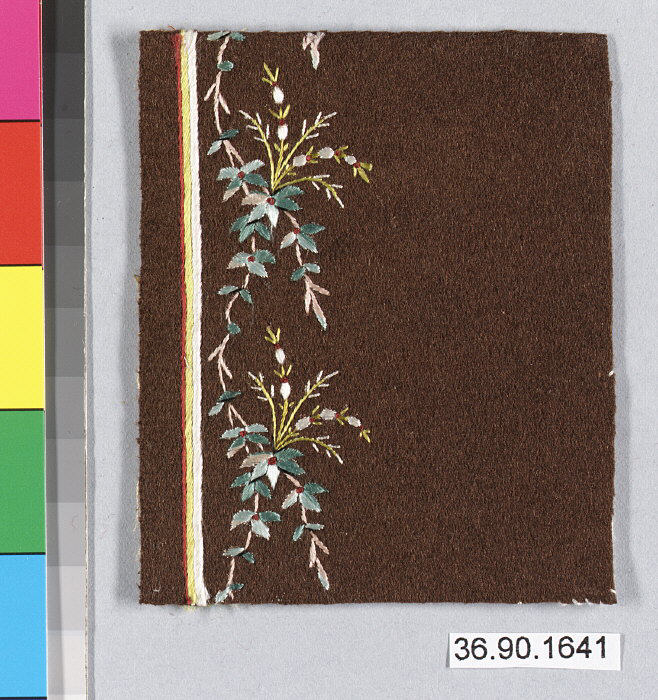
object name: sample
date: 1801-1833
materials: felt, silk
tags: flowers